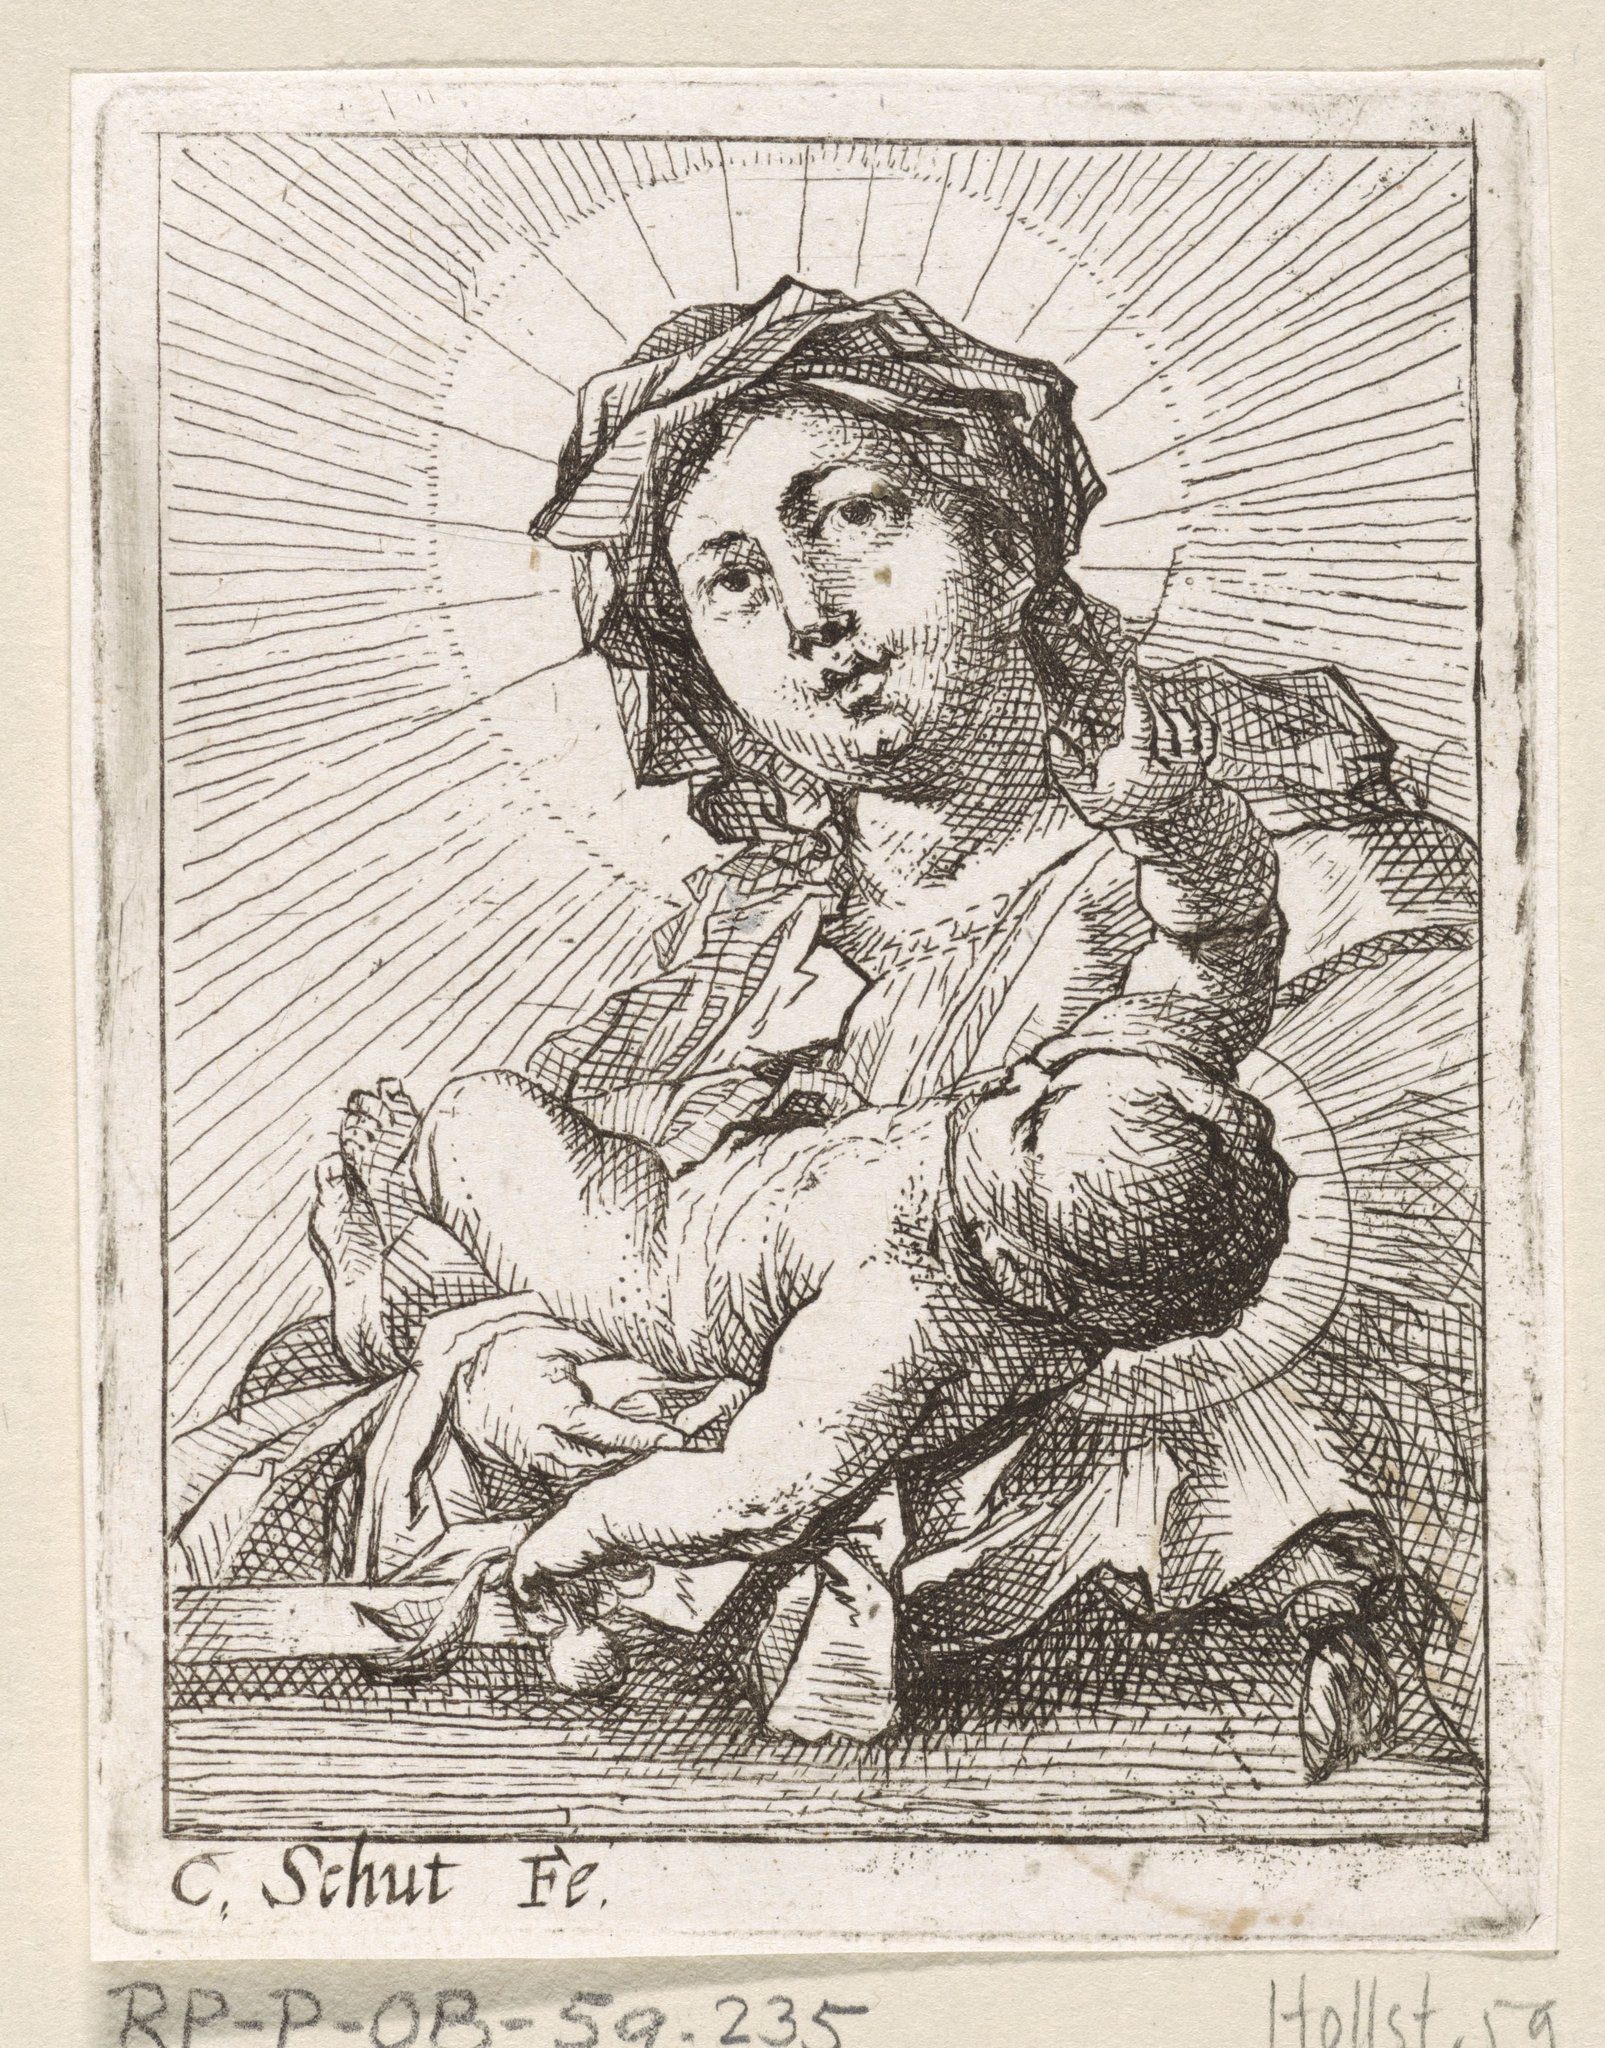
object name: print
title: Madonna met kind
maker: cornelis schut (i)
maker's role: draughtsman, print maker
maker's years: 1597-1655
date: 1618-1655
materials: paper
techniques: etching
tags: madonna: mary sitting or enthroned, the christ-child in her lap (or in front of her bosom) (mary sometimes represented half-length)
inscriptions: collector's mark: Lugt 240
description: Maria draagt het Christuskind in haar armen. Hij wijst omhoog; in zijn andere hand houdt hij een vrucht.